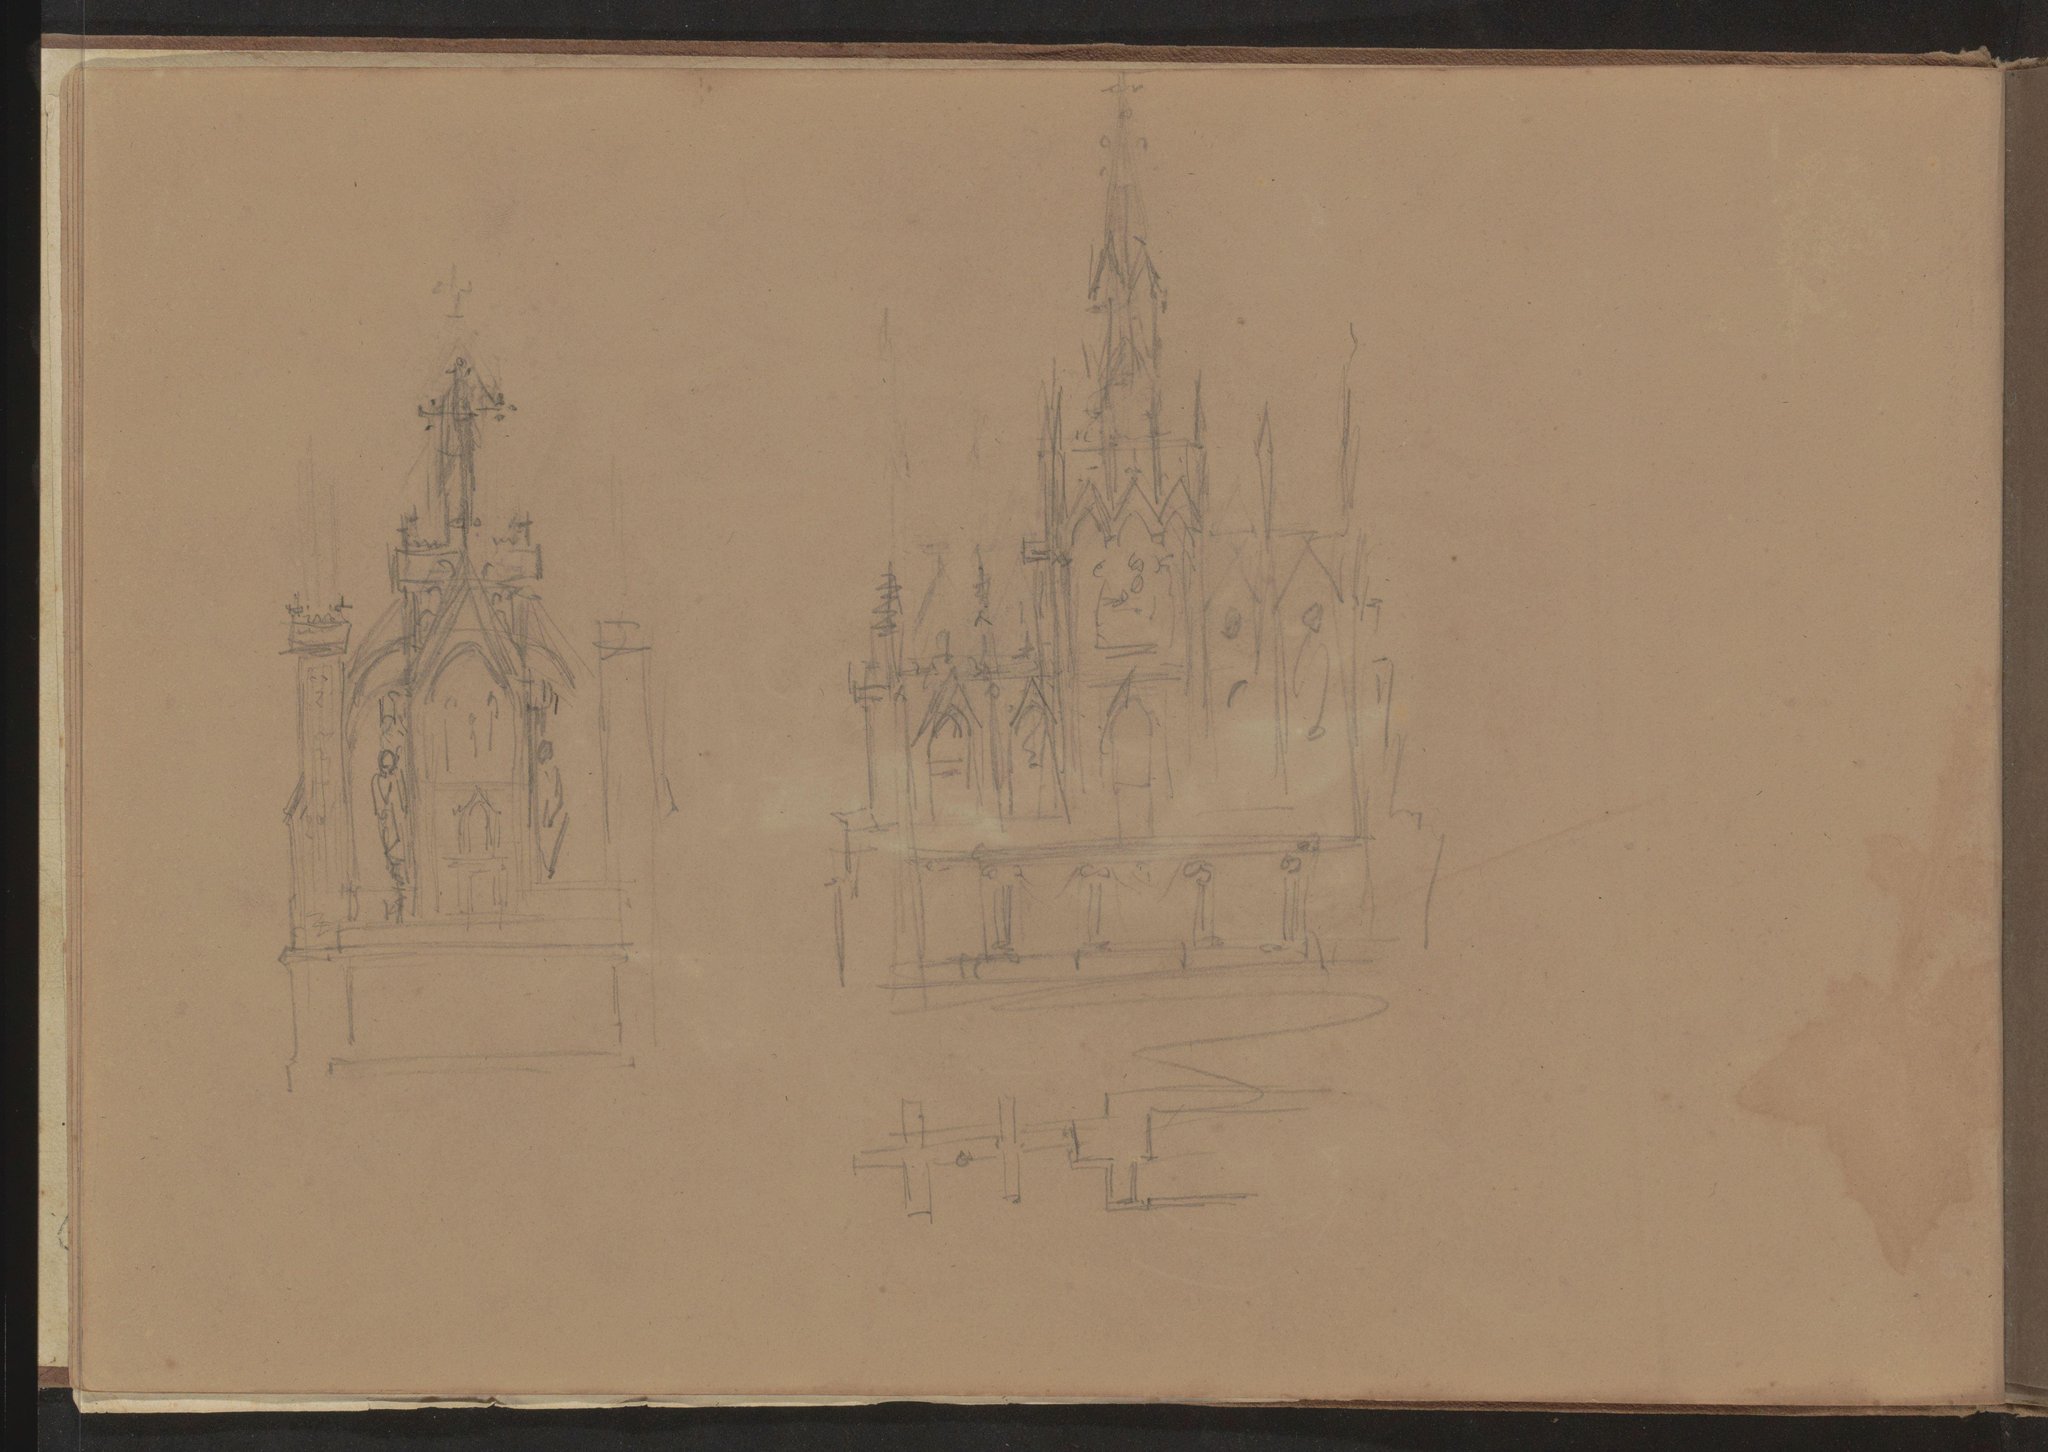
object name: sketchbook leaf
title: Altaren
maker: pierre joseph hubert cuypers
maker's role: draughtsman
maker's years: 1827-1921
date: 1837-1921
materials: paper, pencil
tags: altar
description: Blad 5 verso uit een schetsboek met 23 bladen.